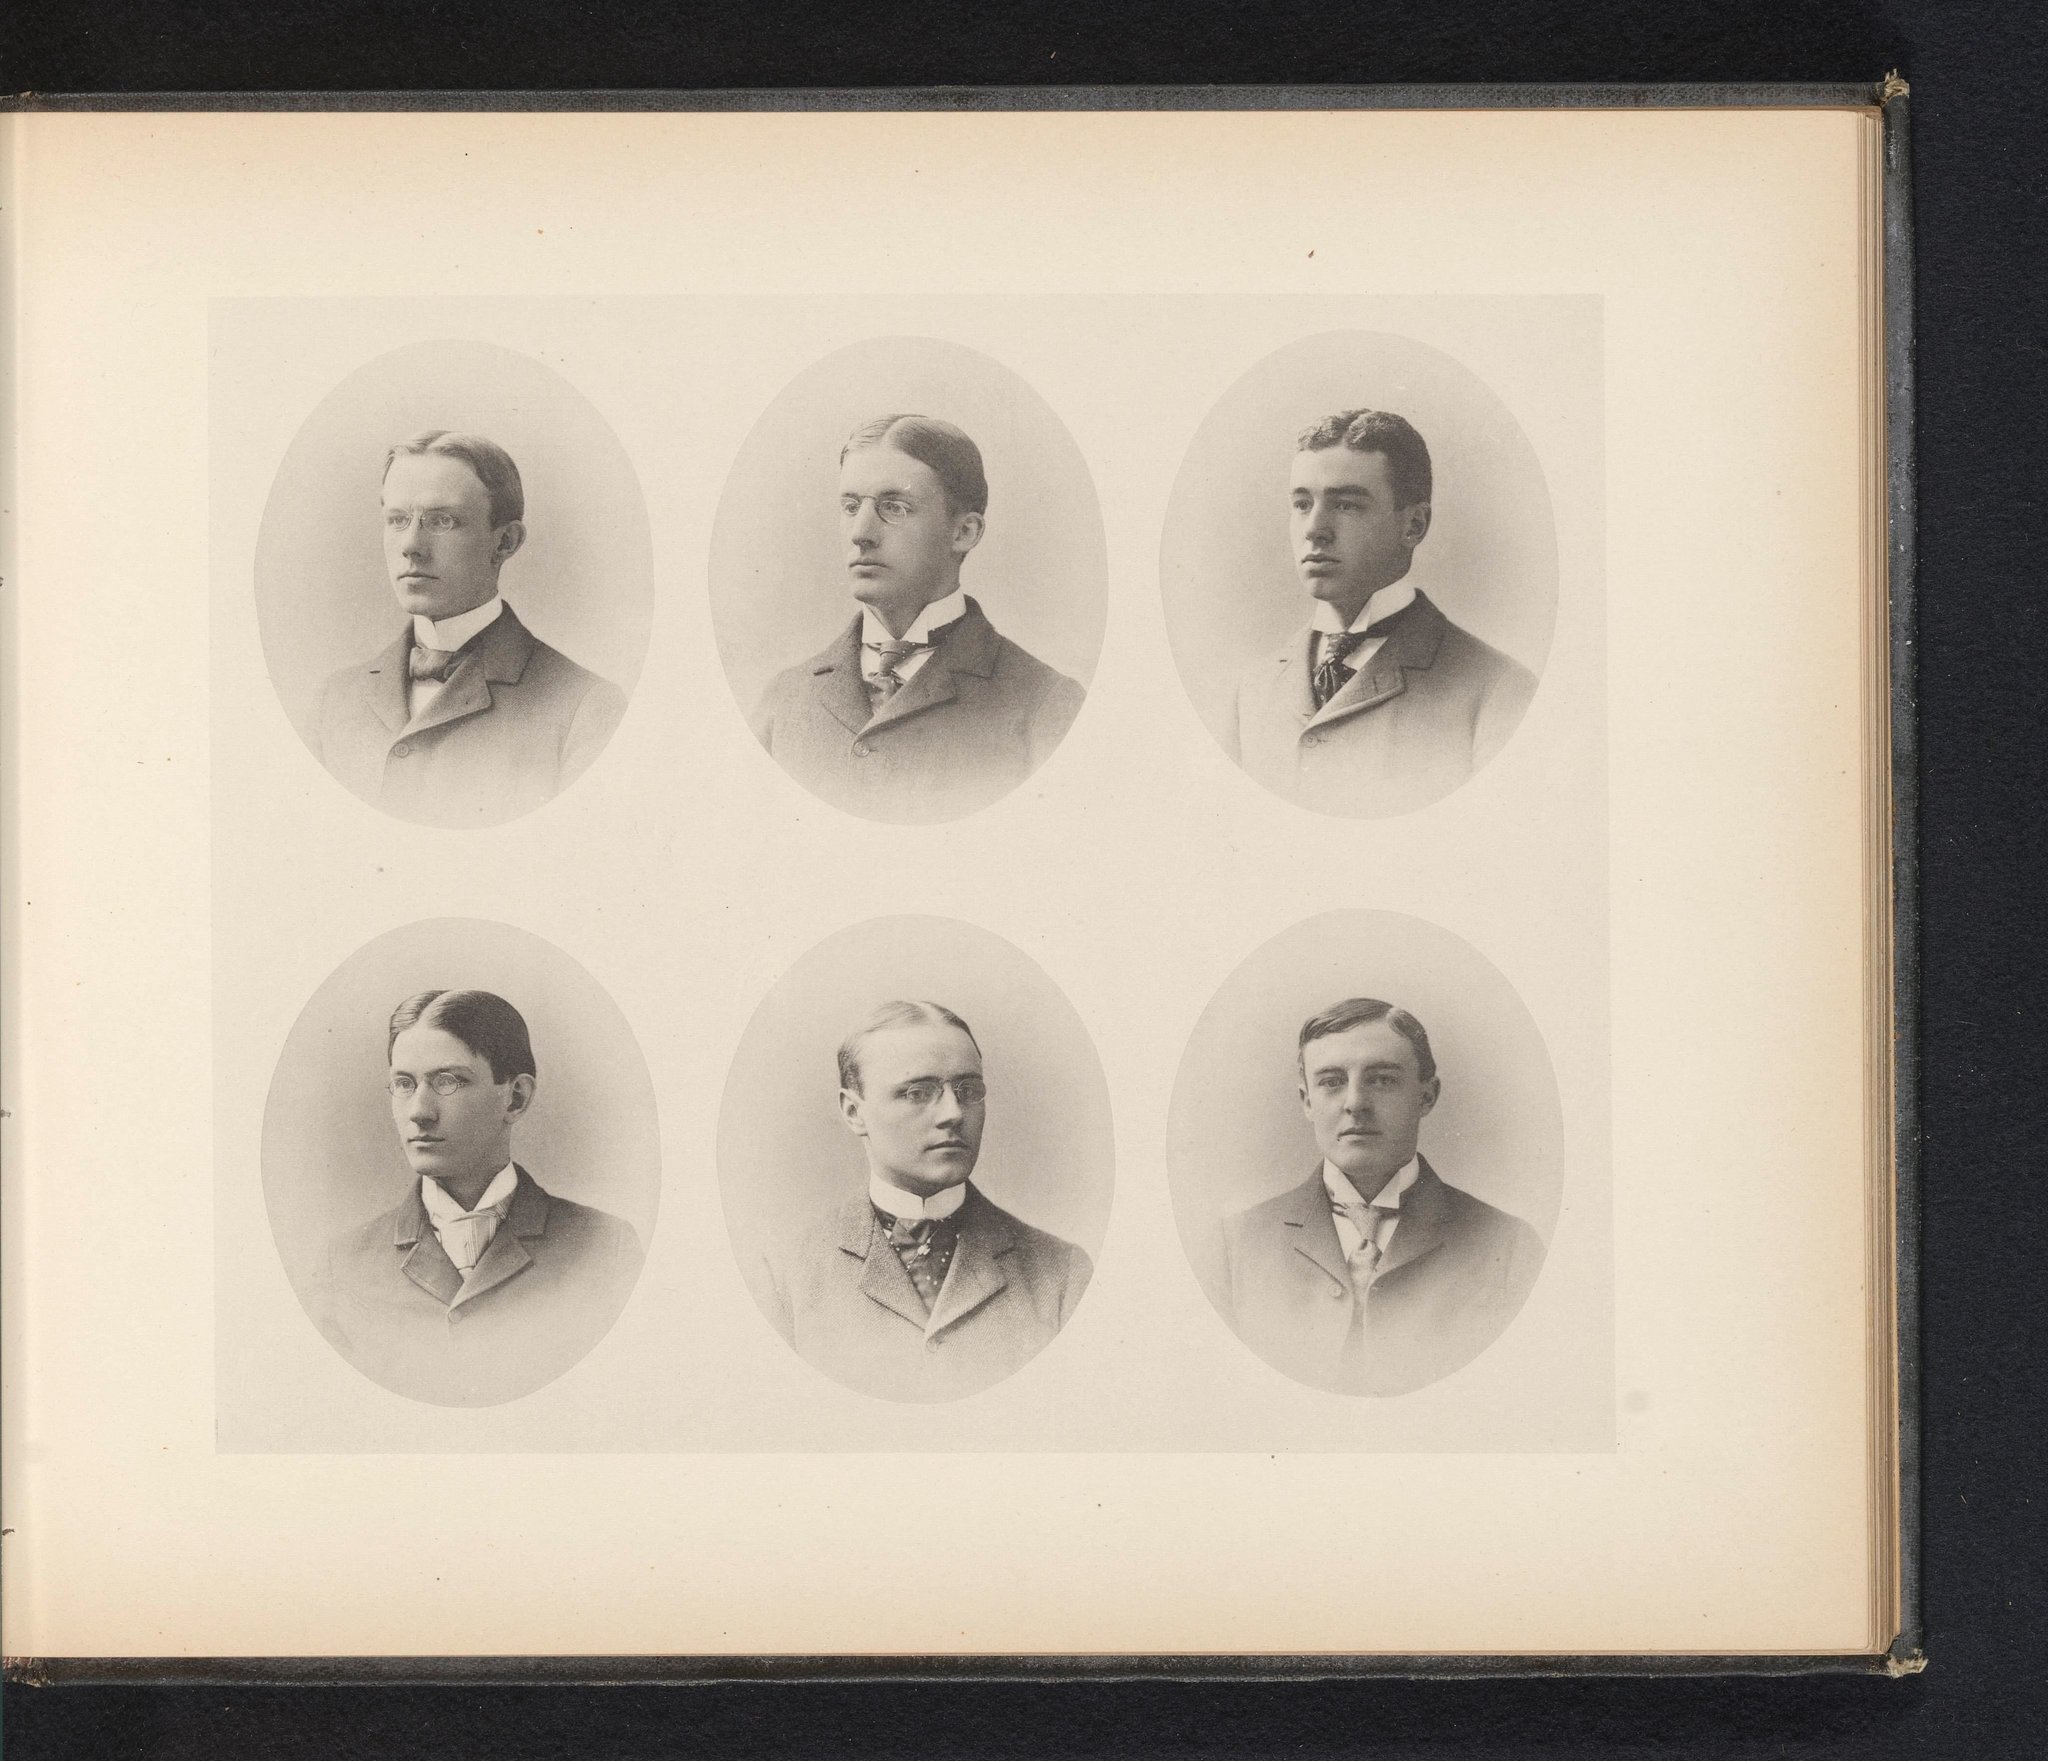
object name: page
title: Zes portretten van afgestudeerde studenten van Yale University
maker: Anonymous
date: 1895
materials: paper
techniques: photograph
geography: new york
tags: student